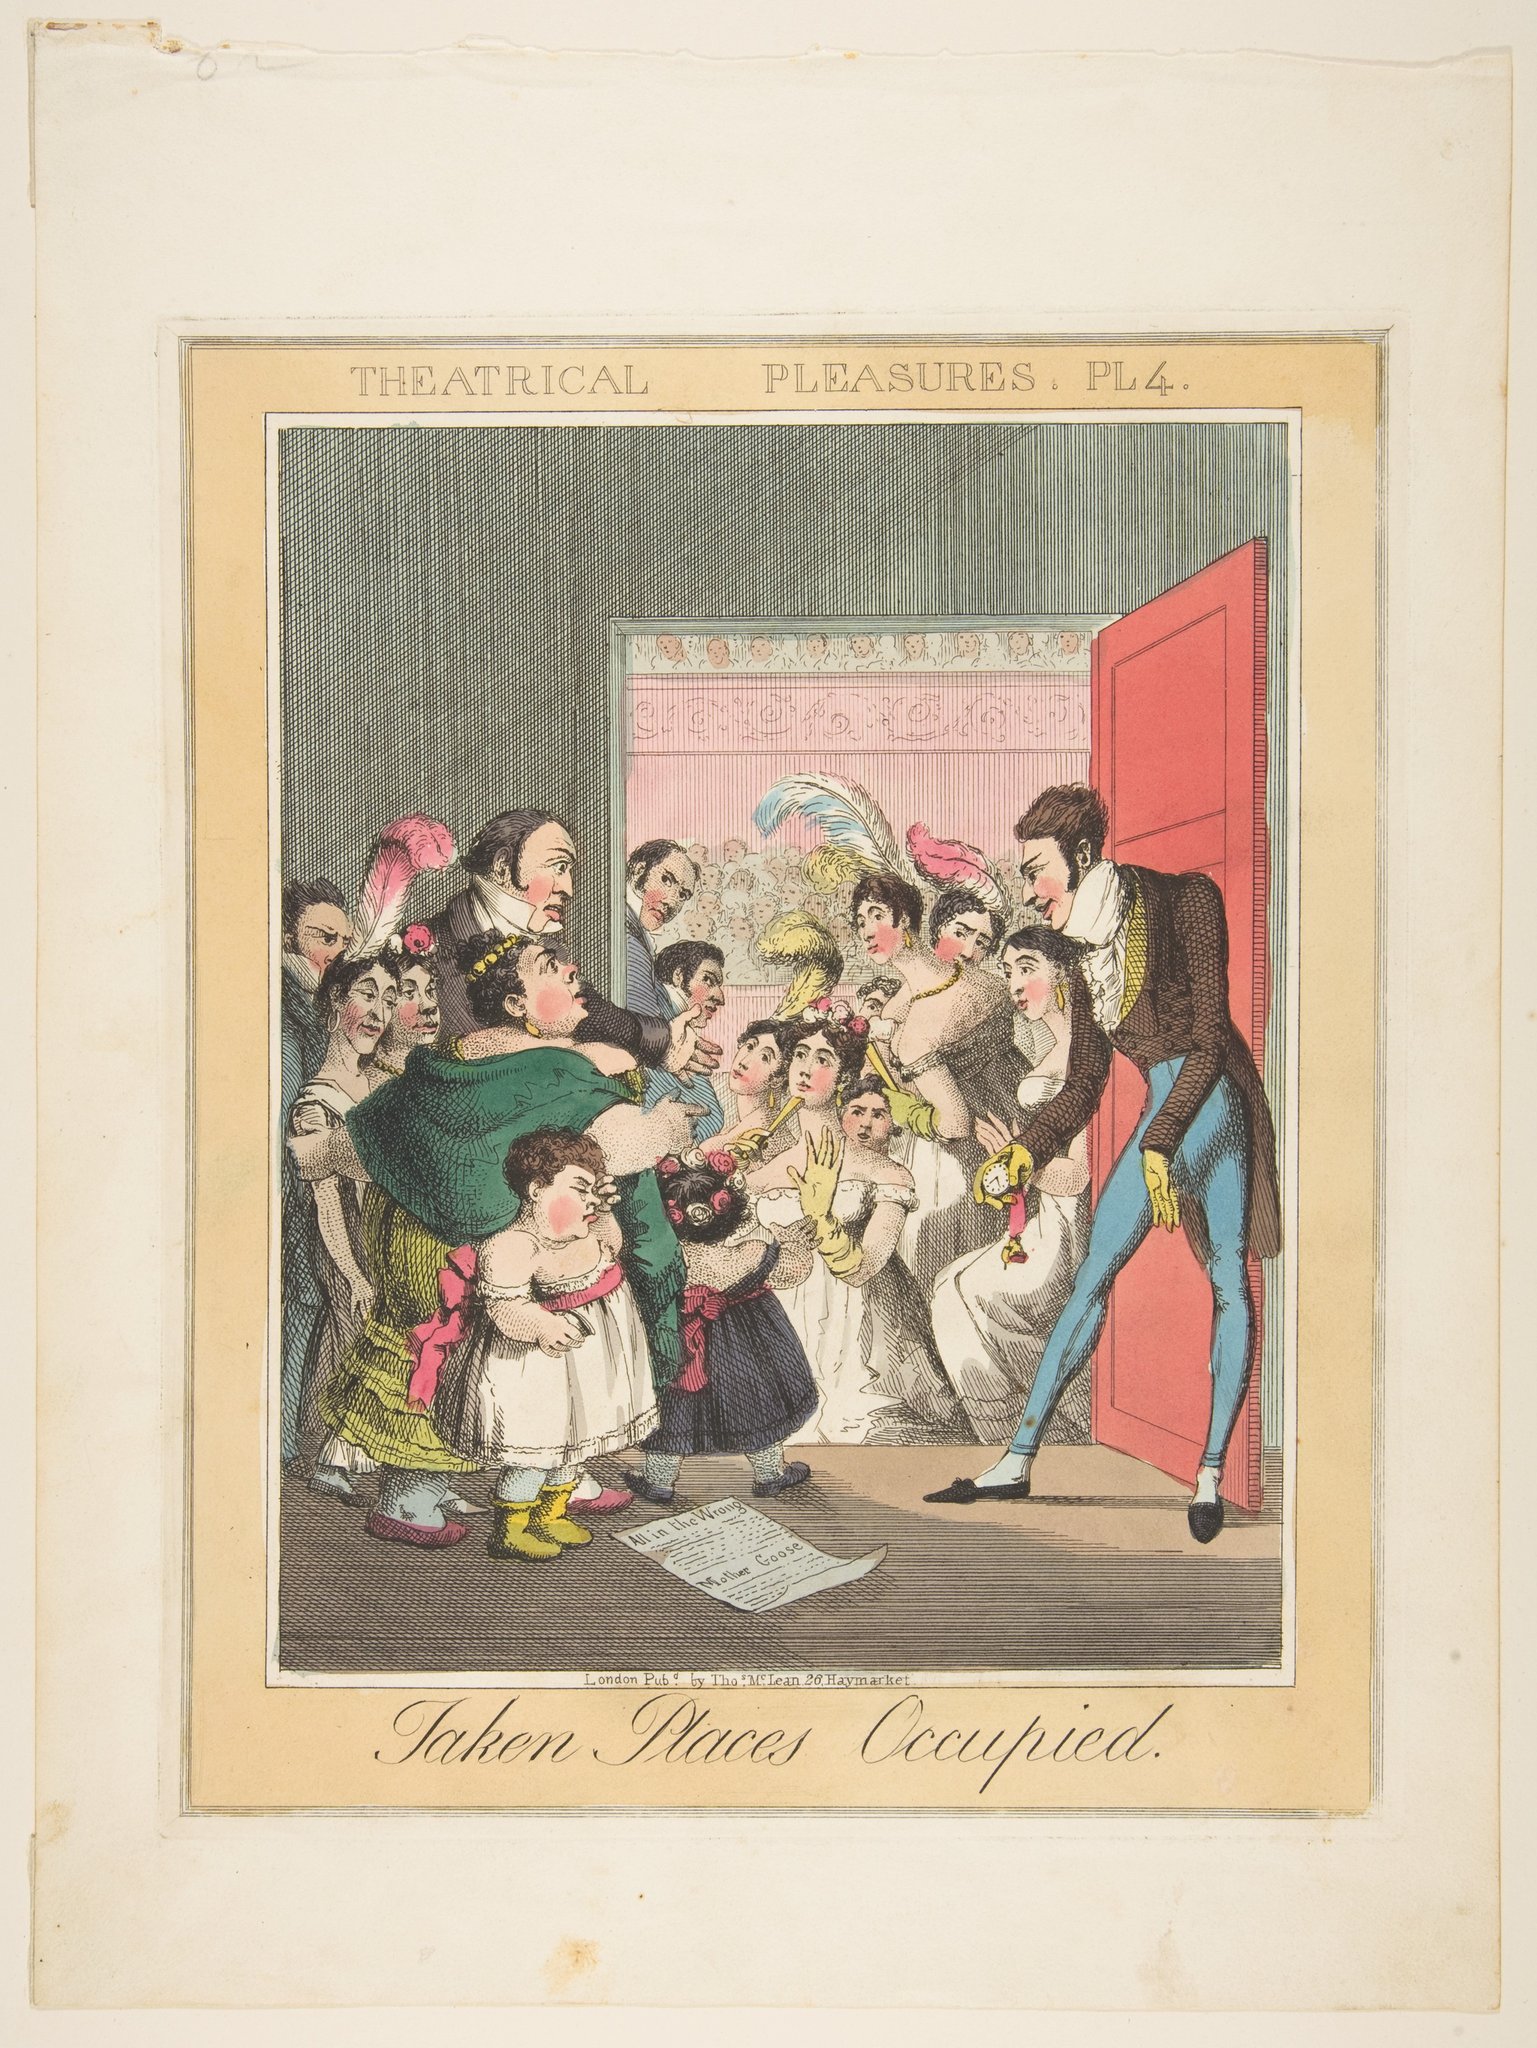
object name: print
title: Theatrical Pleasures, Plate 4: Taken Places Occupied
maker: theodore lane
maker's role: artist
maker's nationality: british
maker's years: 1800-1828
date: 1835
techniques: etching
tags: girls,men,women